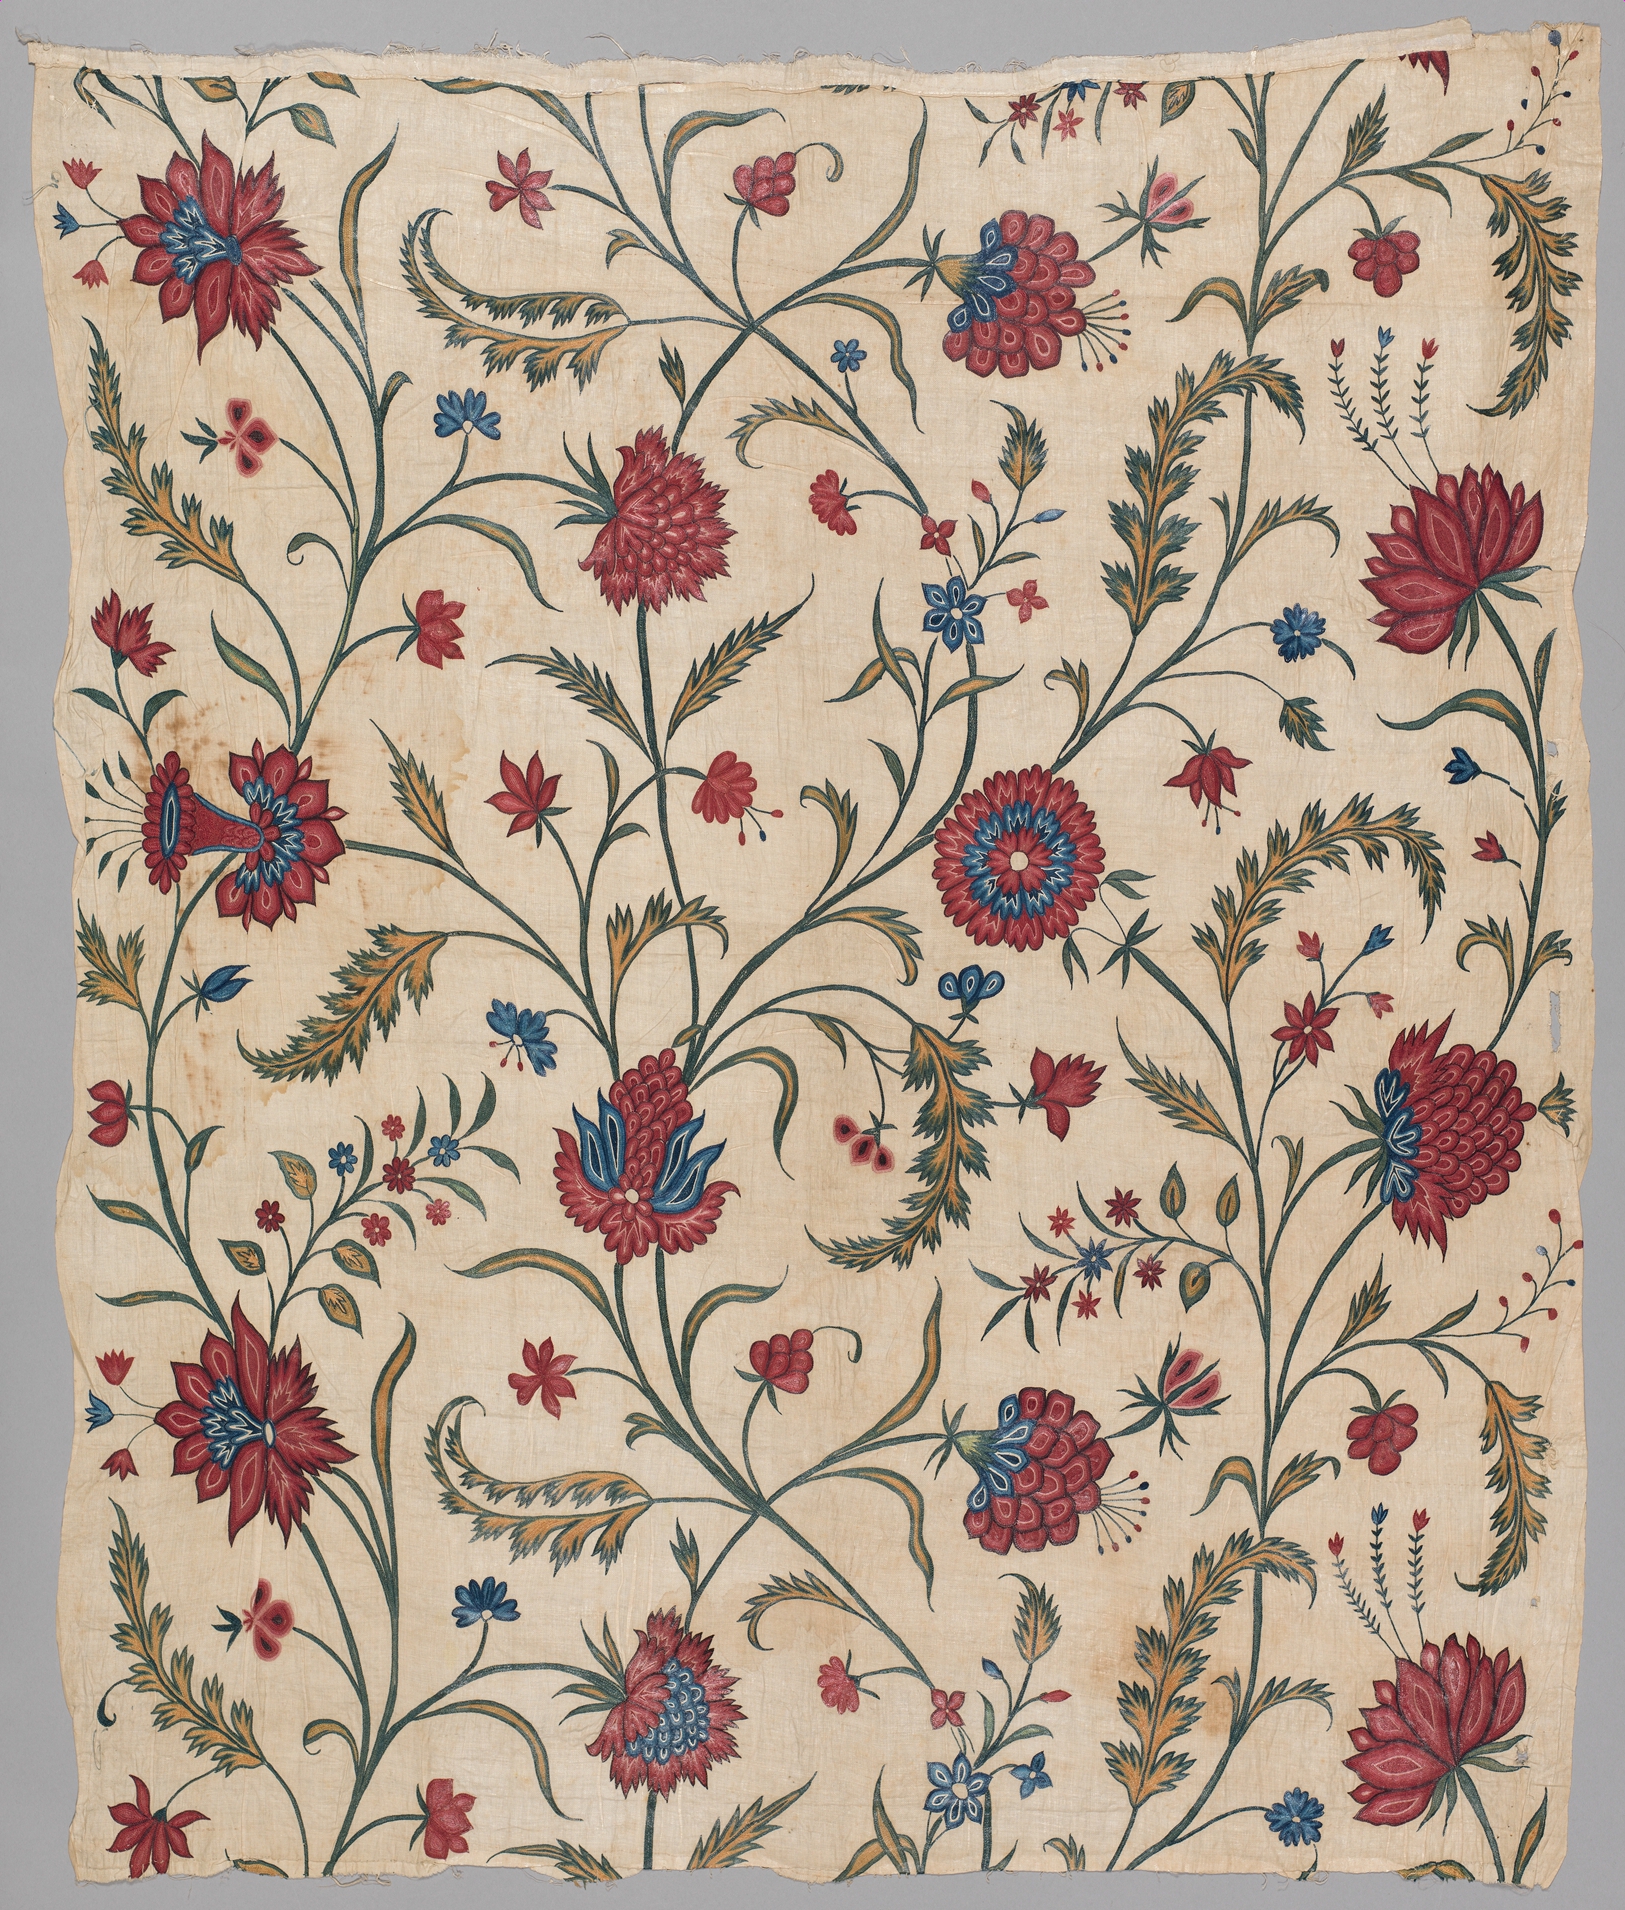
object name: panel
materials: cotton, silk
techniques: embroidery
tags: flowers,leaves